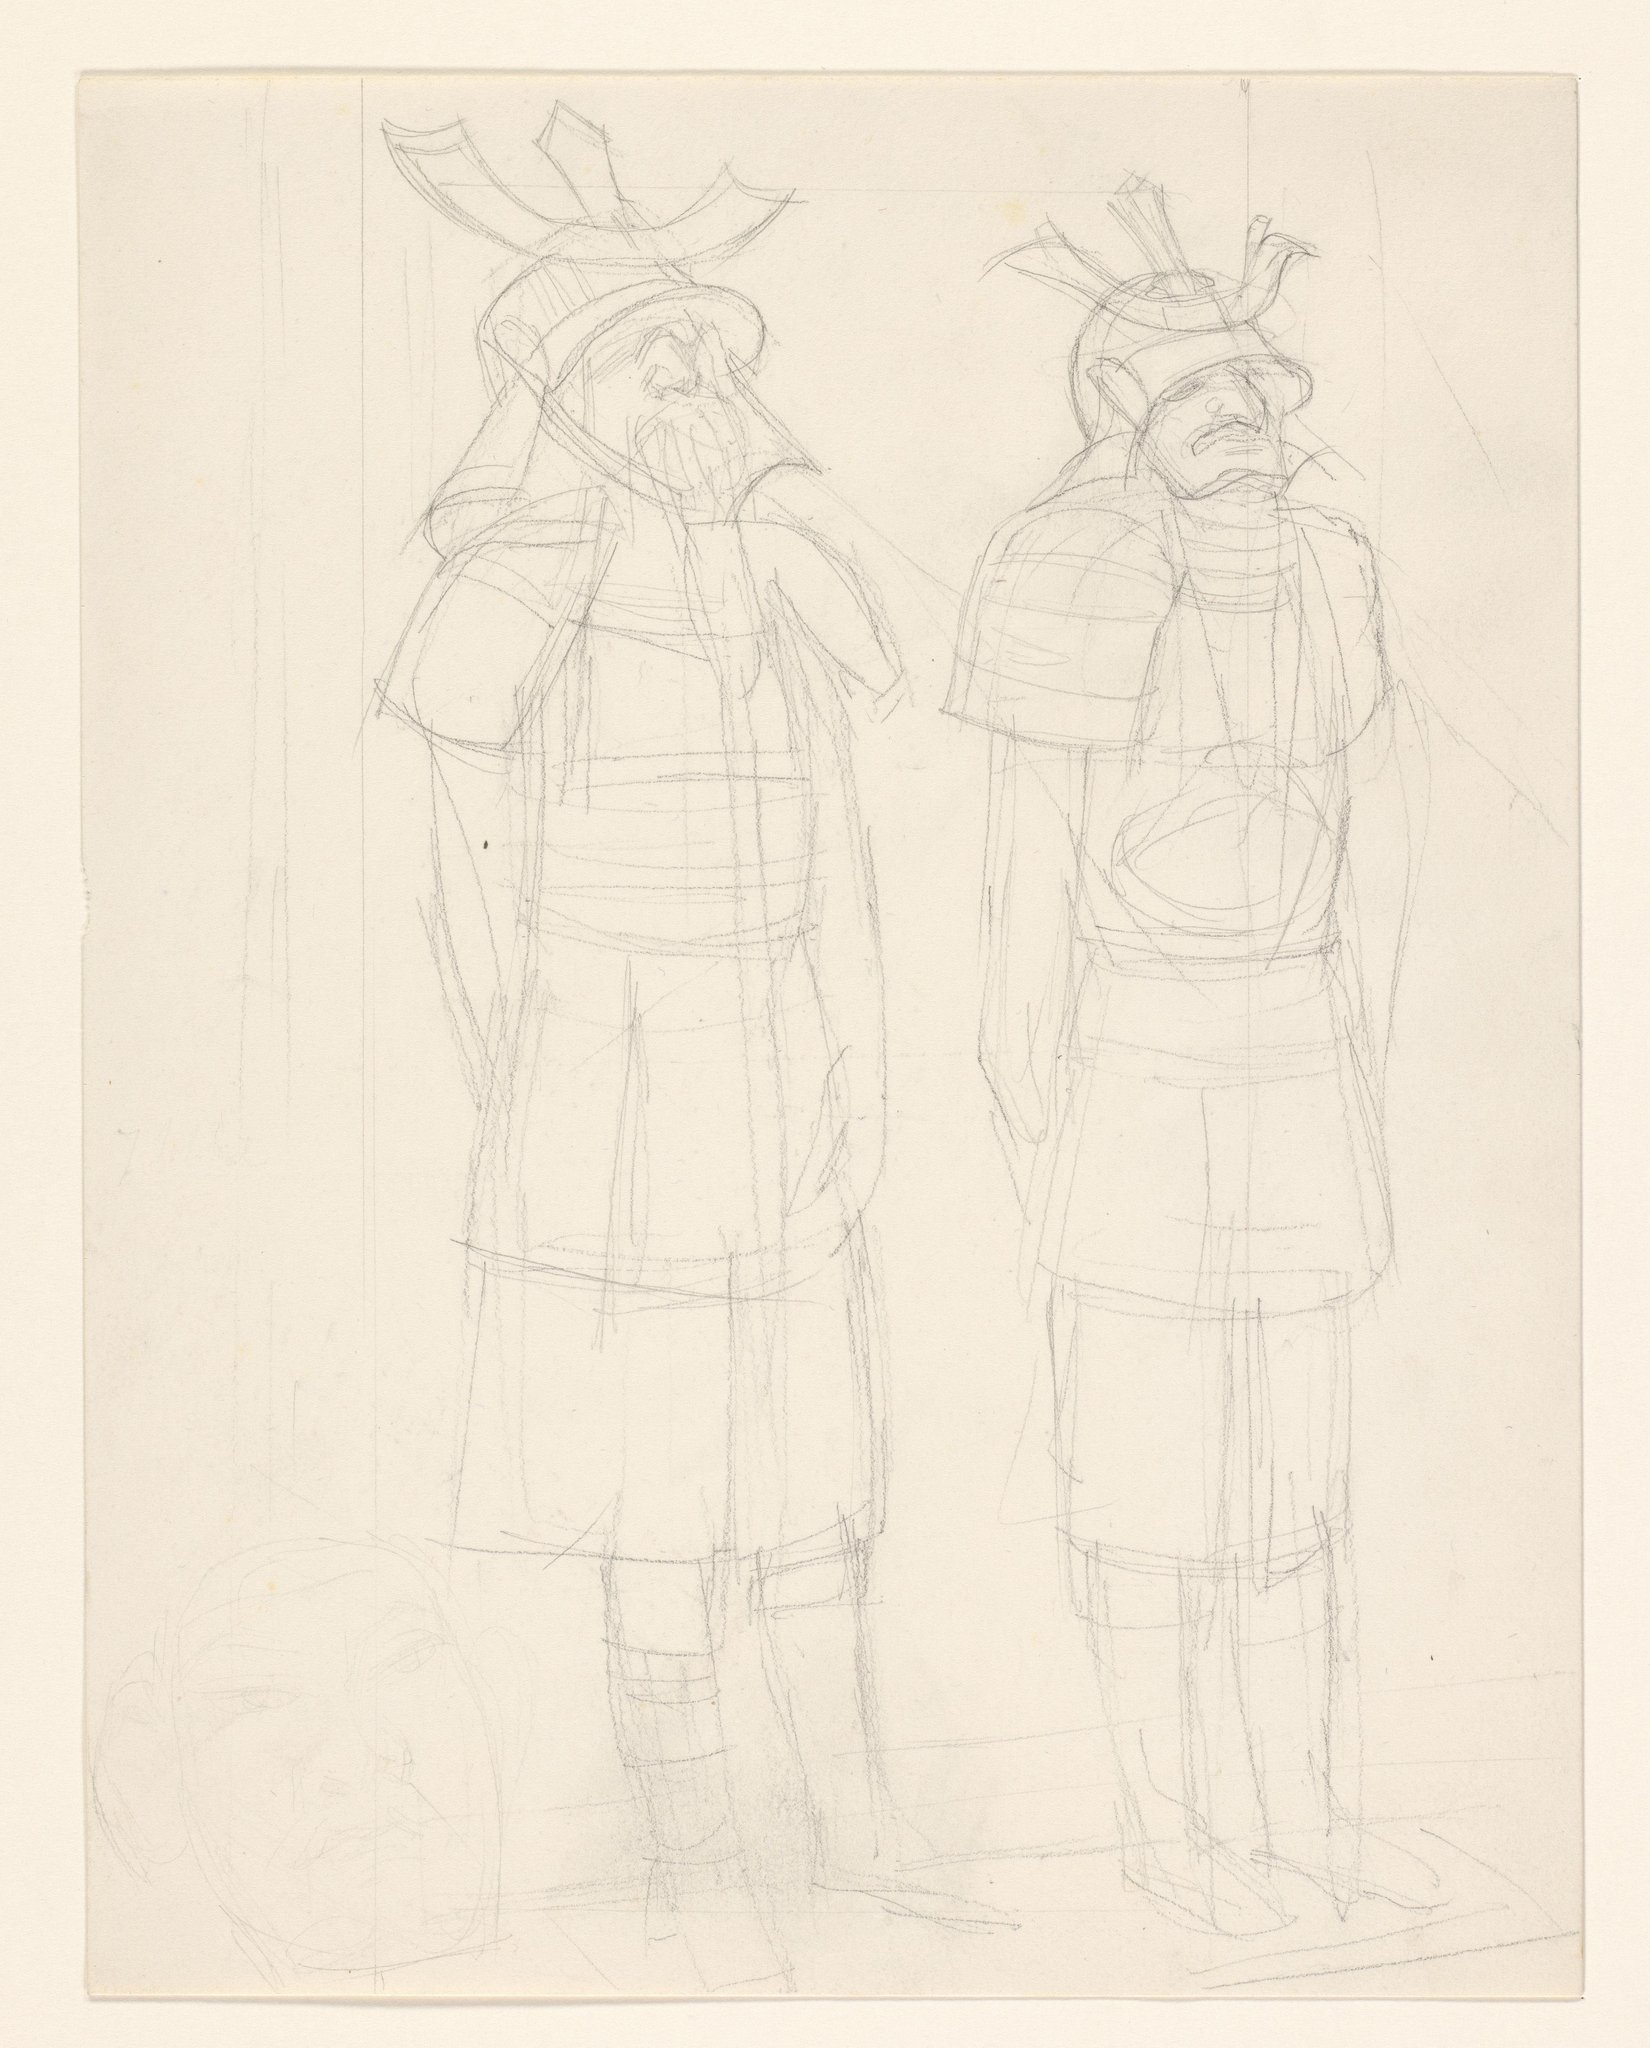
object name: drawing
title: Twee op wacht staande soldaten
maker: august allebé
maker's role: draughtsman, print maker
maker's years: 1838-1927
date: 1848-1927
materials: paper, pencil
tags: the (nude) human figure; 'corpo humano' (ripa), piece of sculpture, reproduction of a piece of sculpture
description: Studie van beeldhouwwerken in het Museum voor Volkenkunde.